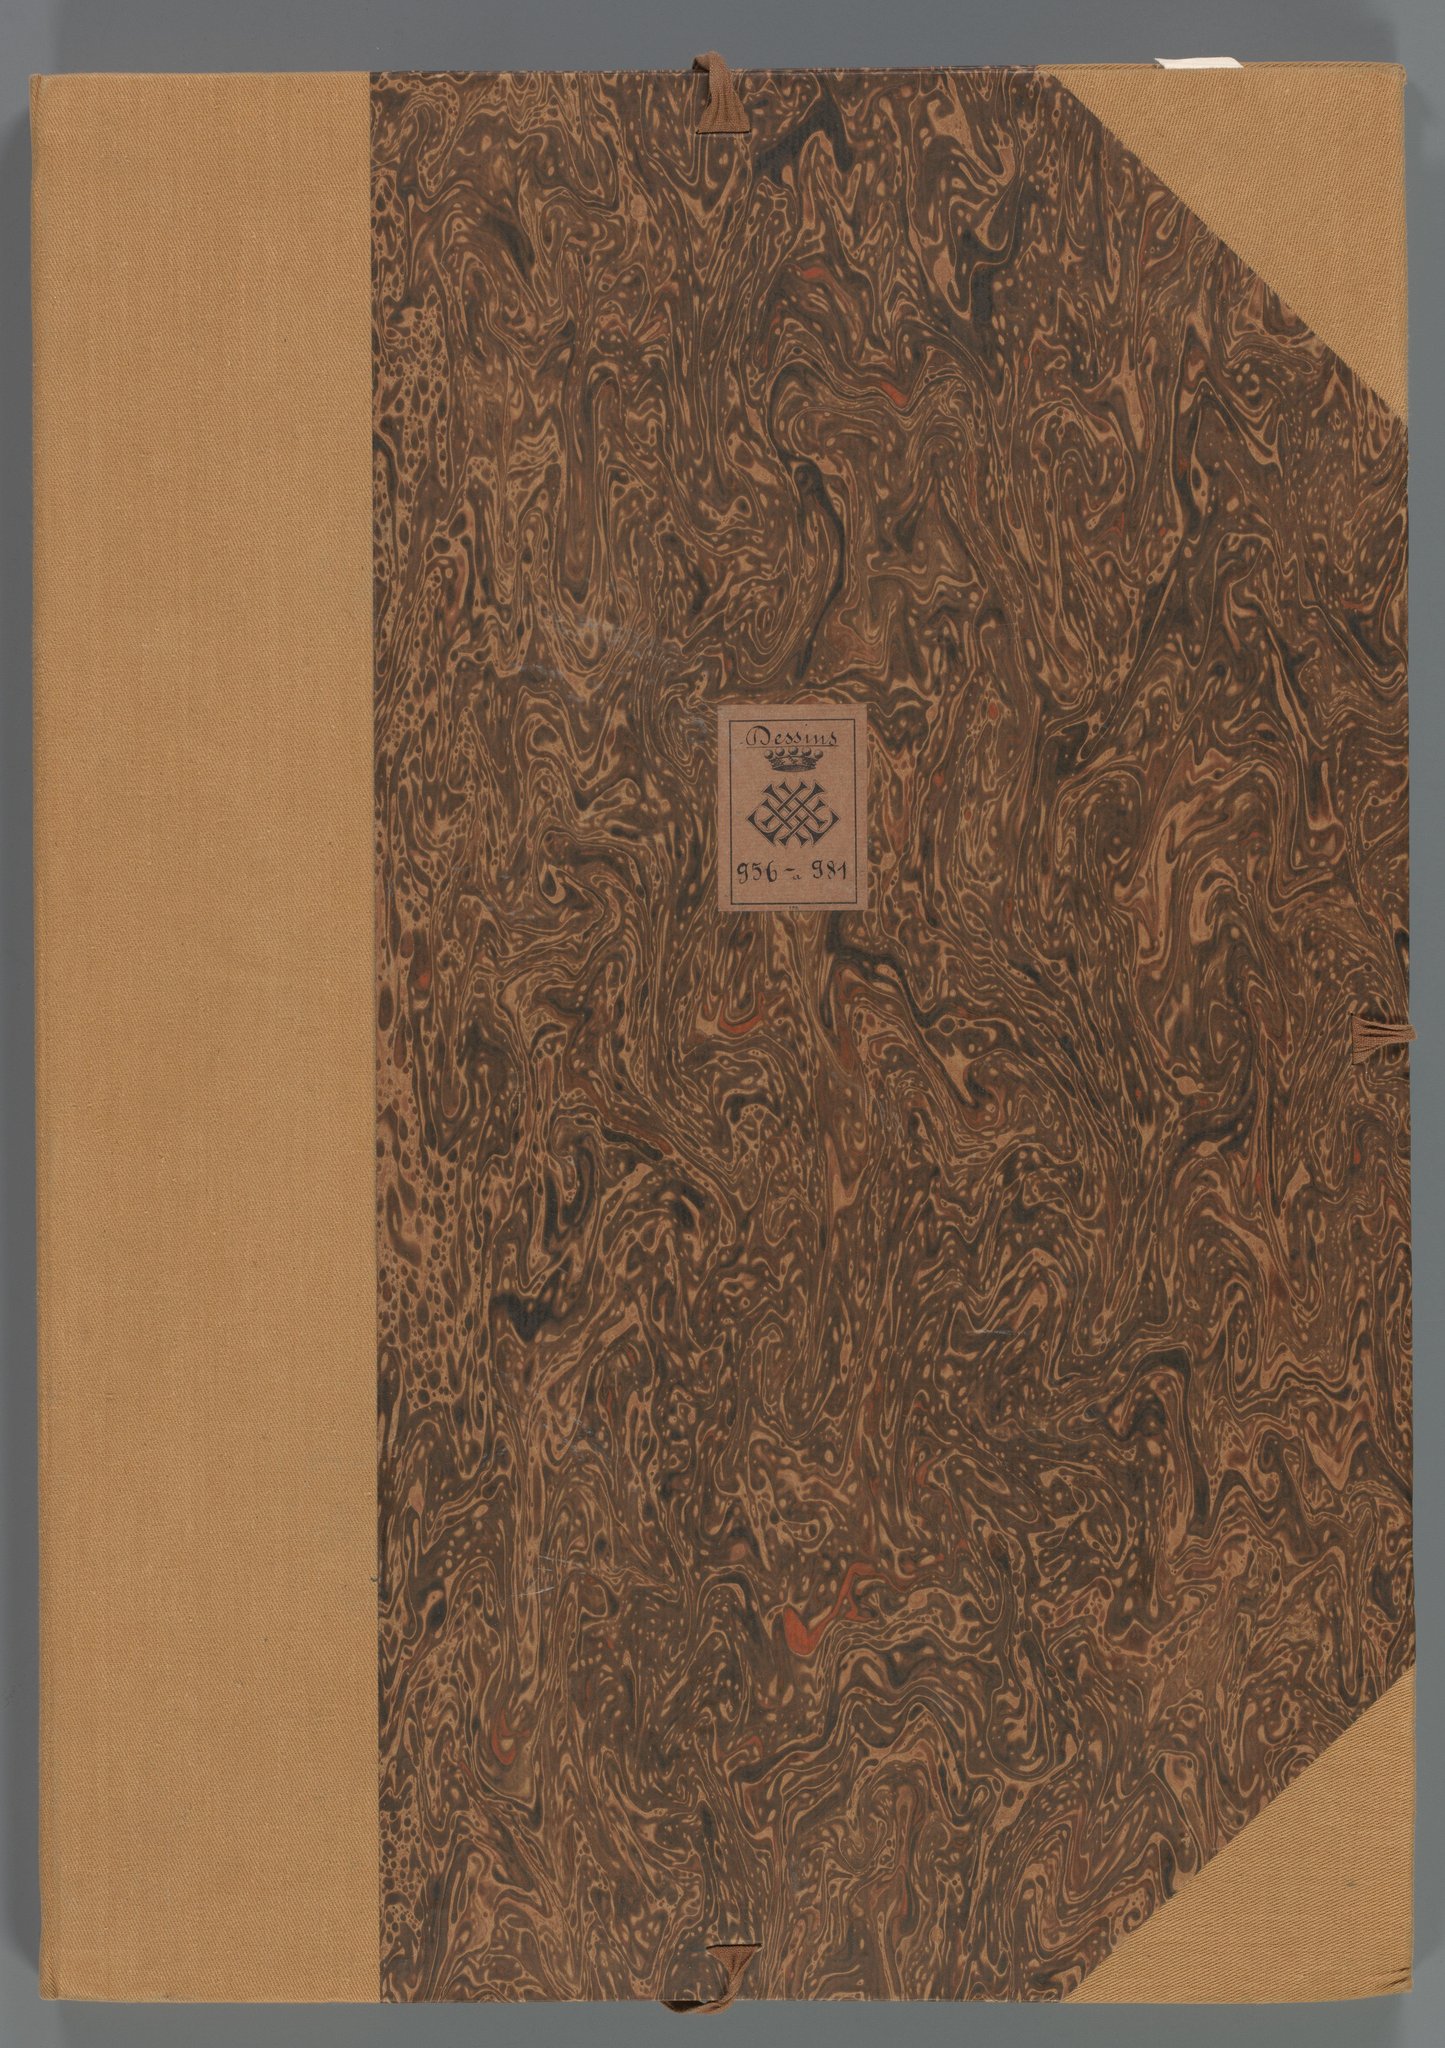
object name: wrapper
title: Omslag voor 27 tekeningen met Italiaanse landschappen door Christoph Heinrich Kniep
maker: Anonymous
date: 1900-1925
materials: linen, paper, ribbon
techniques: marbling, pen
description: Op het schutblad is een handgeschreven notitie geplakt met biografische informatie over Kniep.